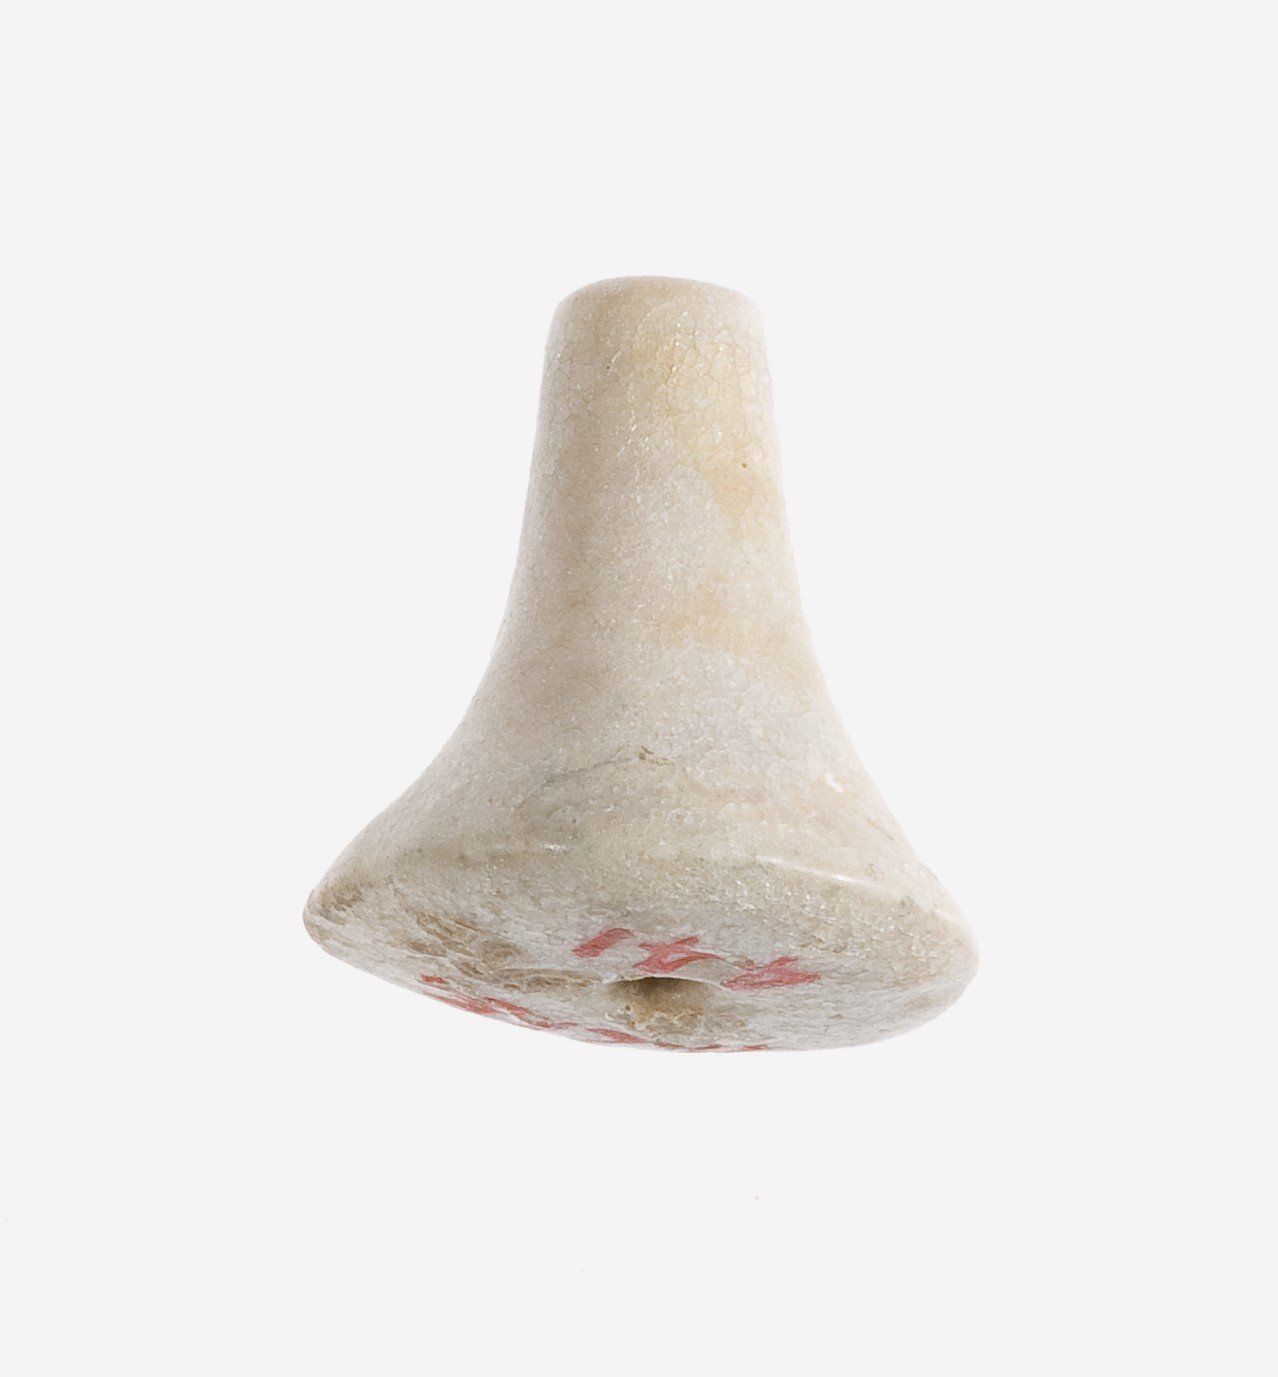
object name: pendant, umbel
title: Umbel Pendant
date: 1390-1352 BCE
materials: faience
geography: egypt